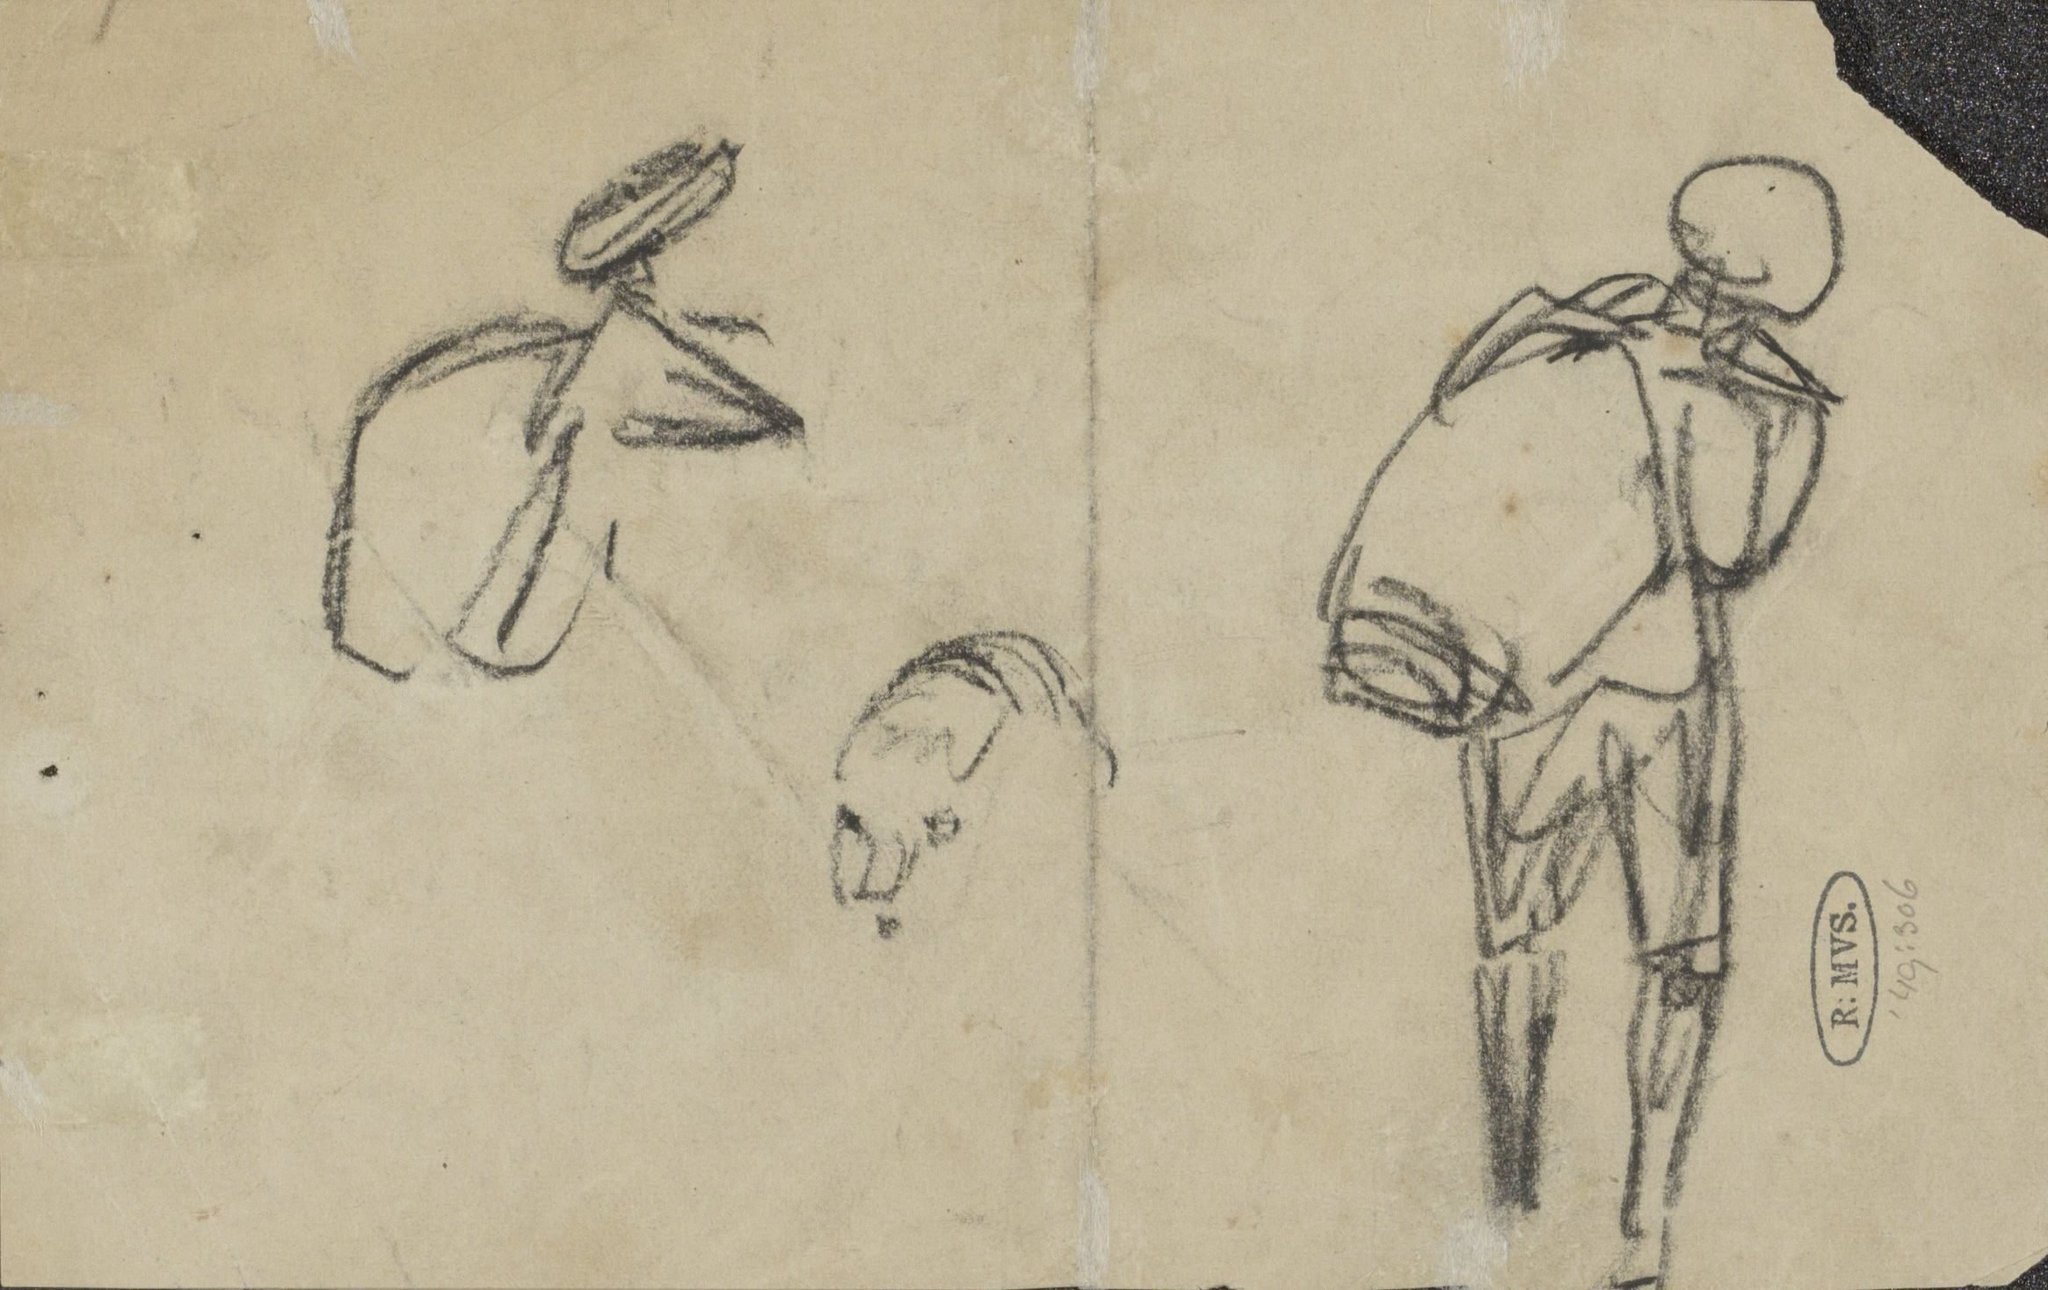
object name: drawing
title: Studies van een zakkendrager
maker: george hendrik breitner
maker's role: draughtsman, painter, print maker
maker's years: 1857-1923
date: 1886-1923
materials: chalk, paper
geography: amsterdam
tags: carrying something in basket, bag, rucksack, etc.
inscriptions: collector's mark: Lugt 2228